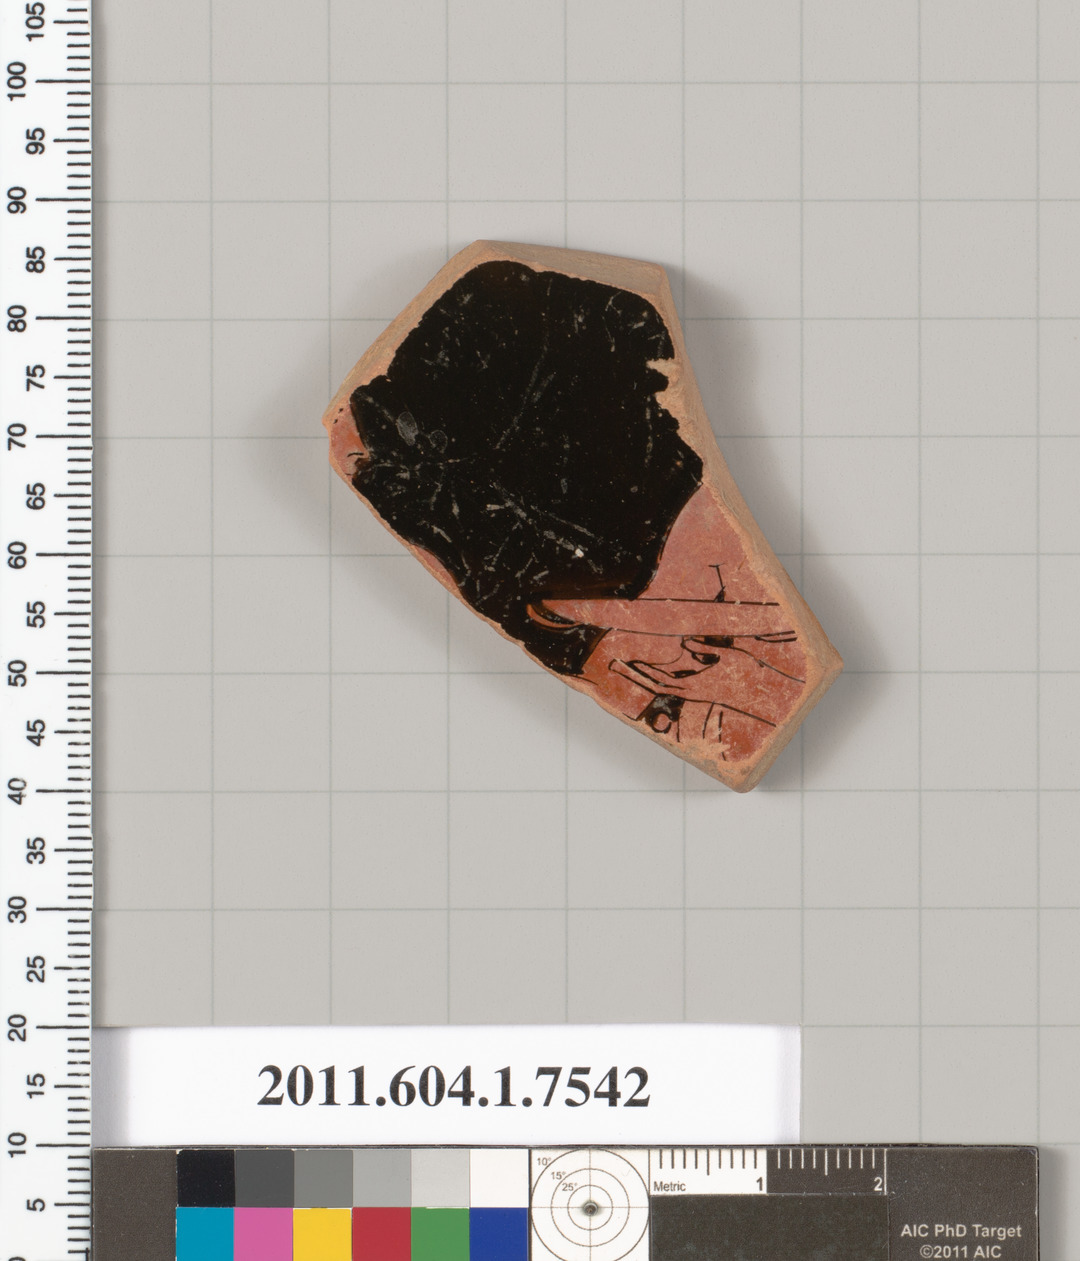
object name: kylix fragment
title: Terracotta fragment of a kylix (drinking cup)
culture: greek, attic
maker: euaion painter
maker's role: artist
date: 460-450 BCE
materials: terracotta